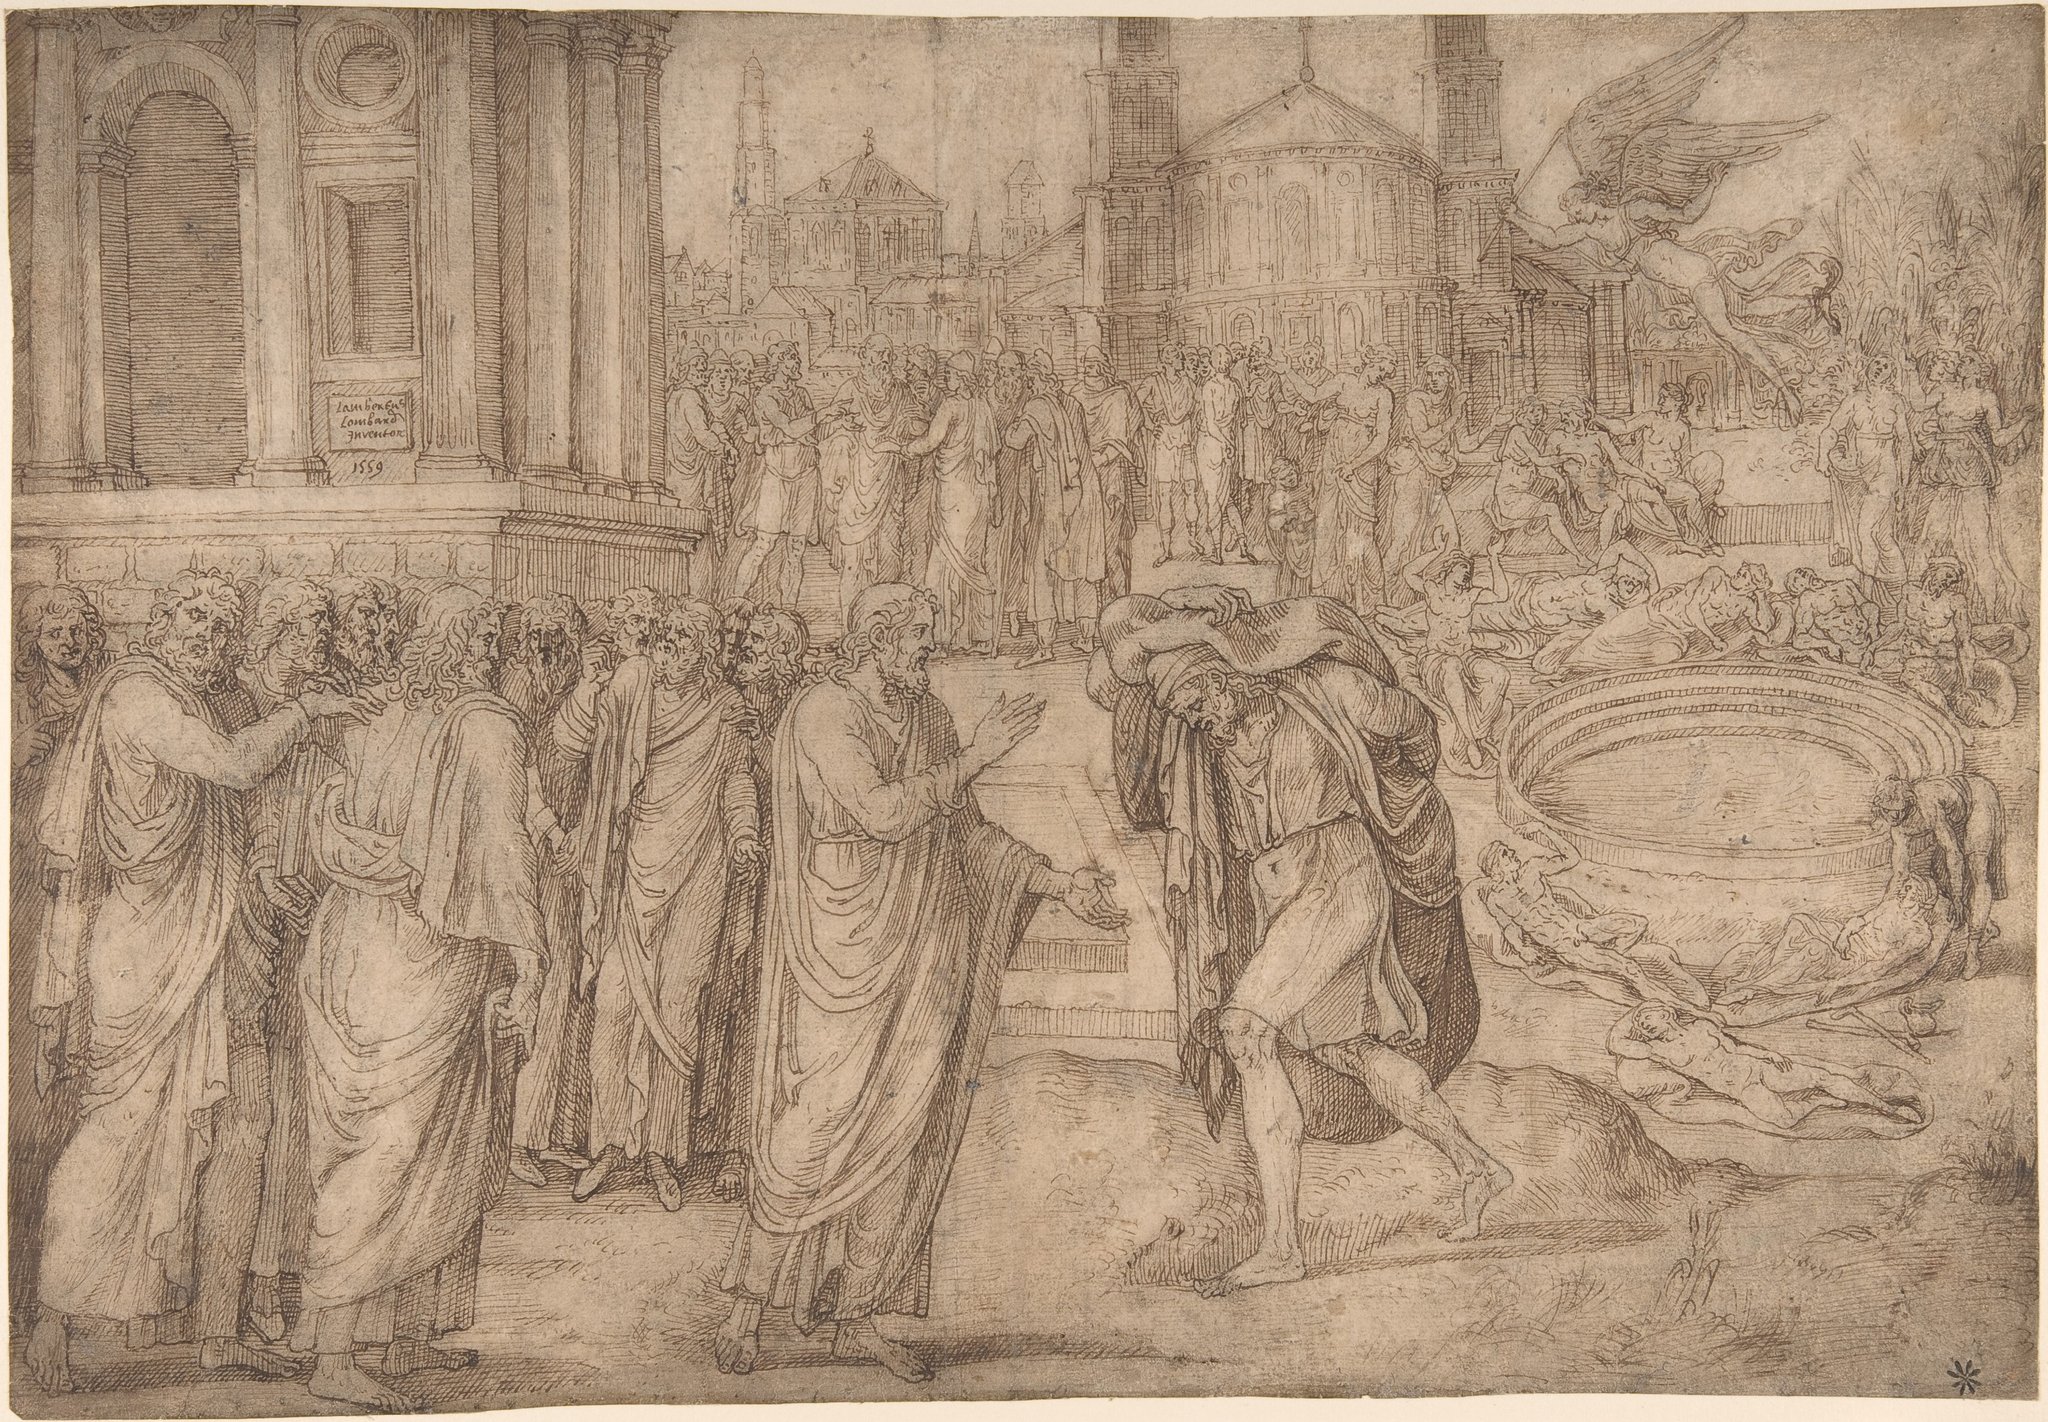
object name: drawing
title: Christ Healing at the Pool of Bethesda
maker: lambert lombard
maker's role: artist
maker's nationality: netherlandish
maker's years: 1506-1566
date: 1501-1600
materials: ink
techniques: pen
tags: angels,christ,crowd